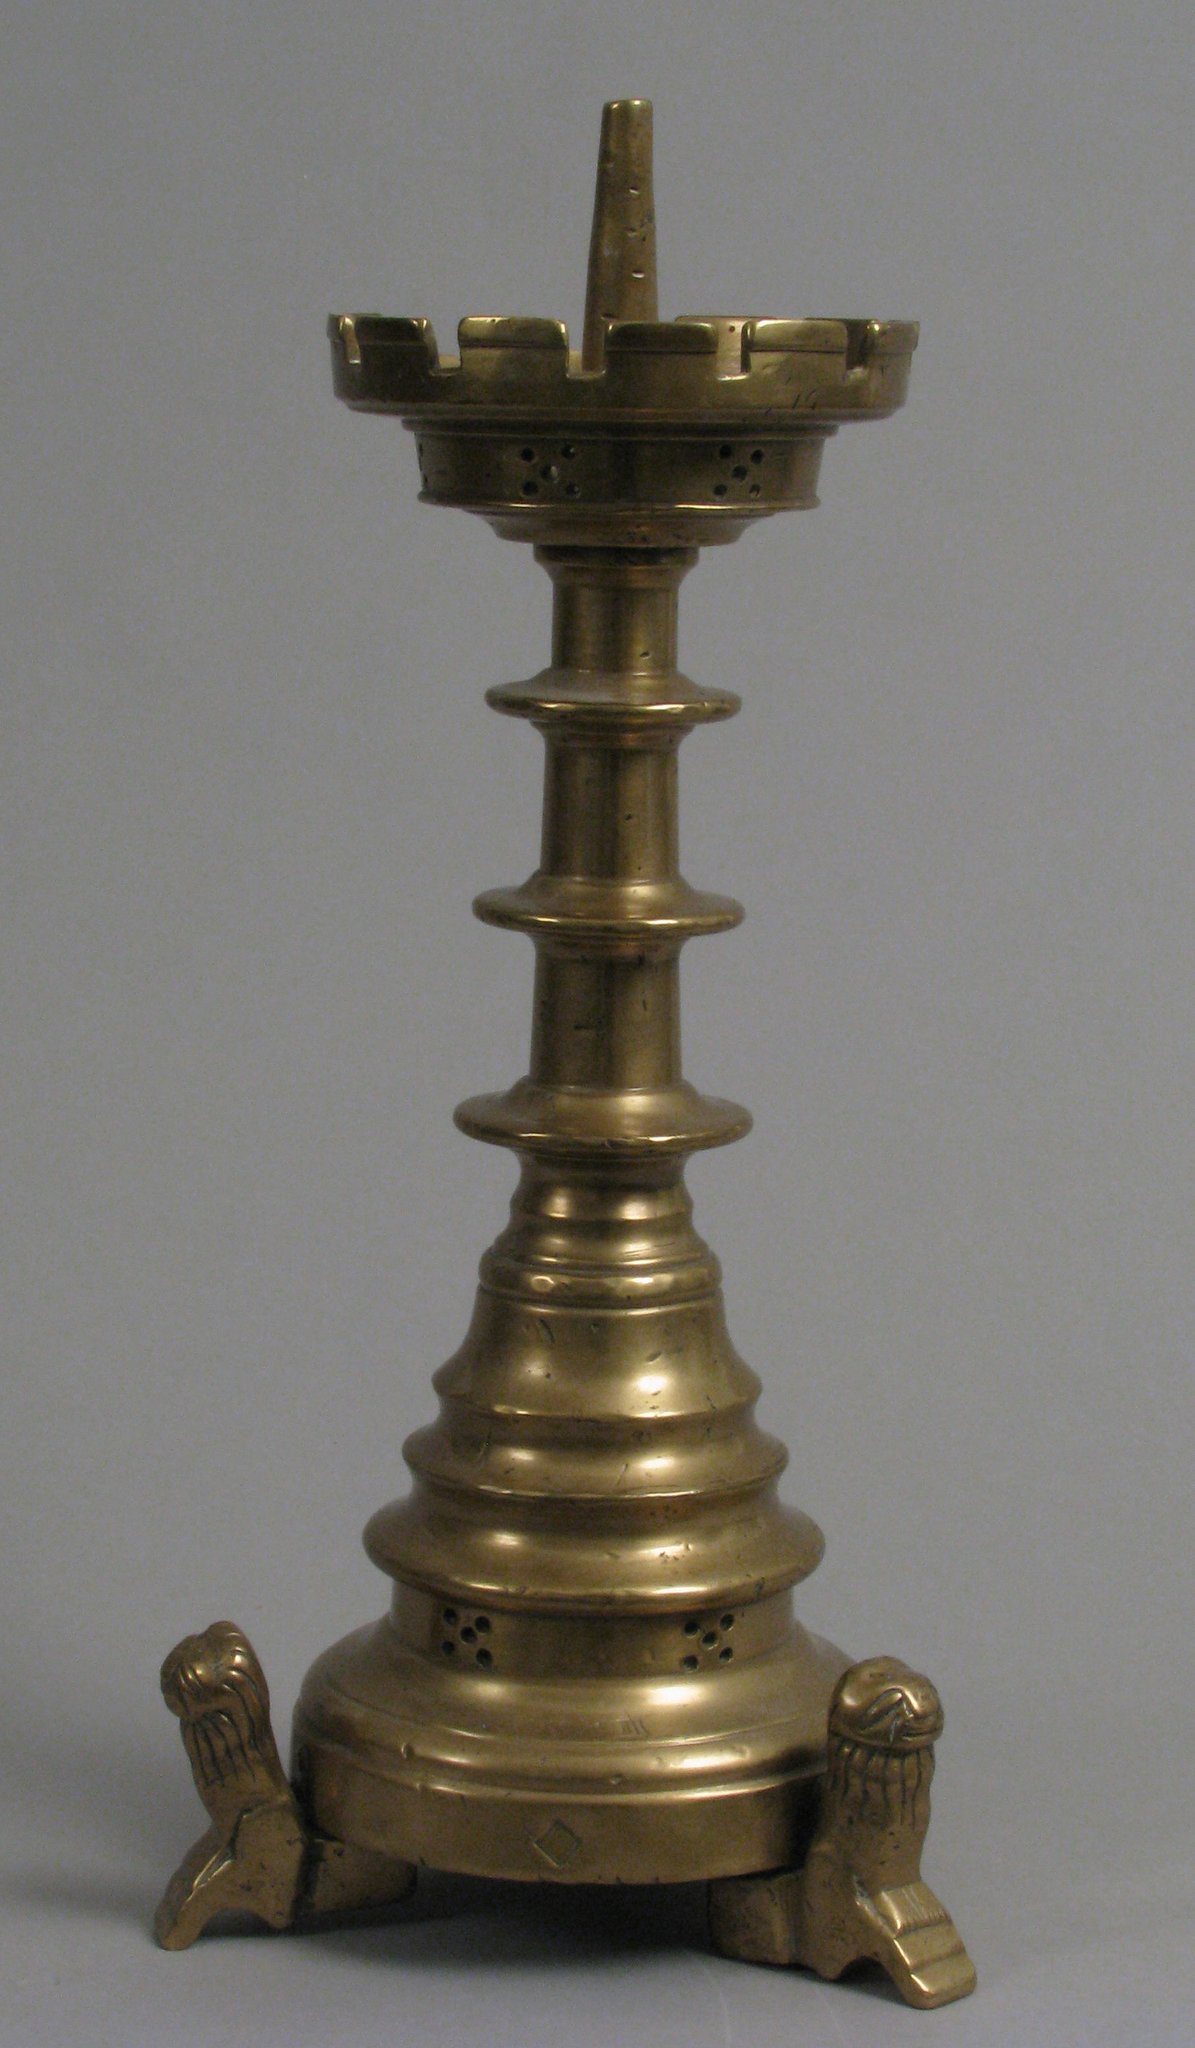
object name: candlestick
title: Candlestick, Pricket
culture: south netherlandish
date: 1401-1500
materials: brass